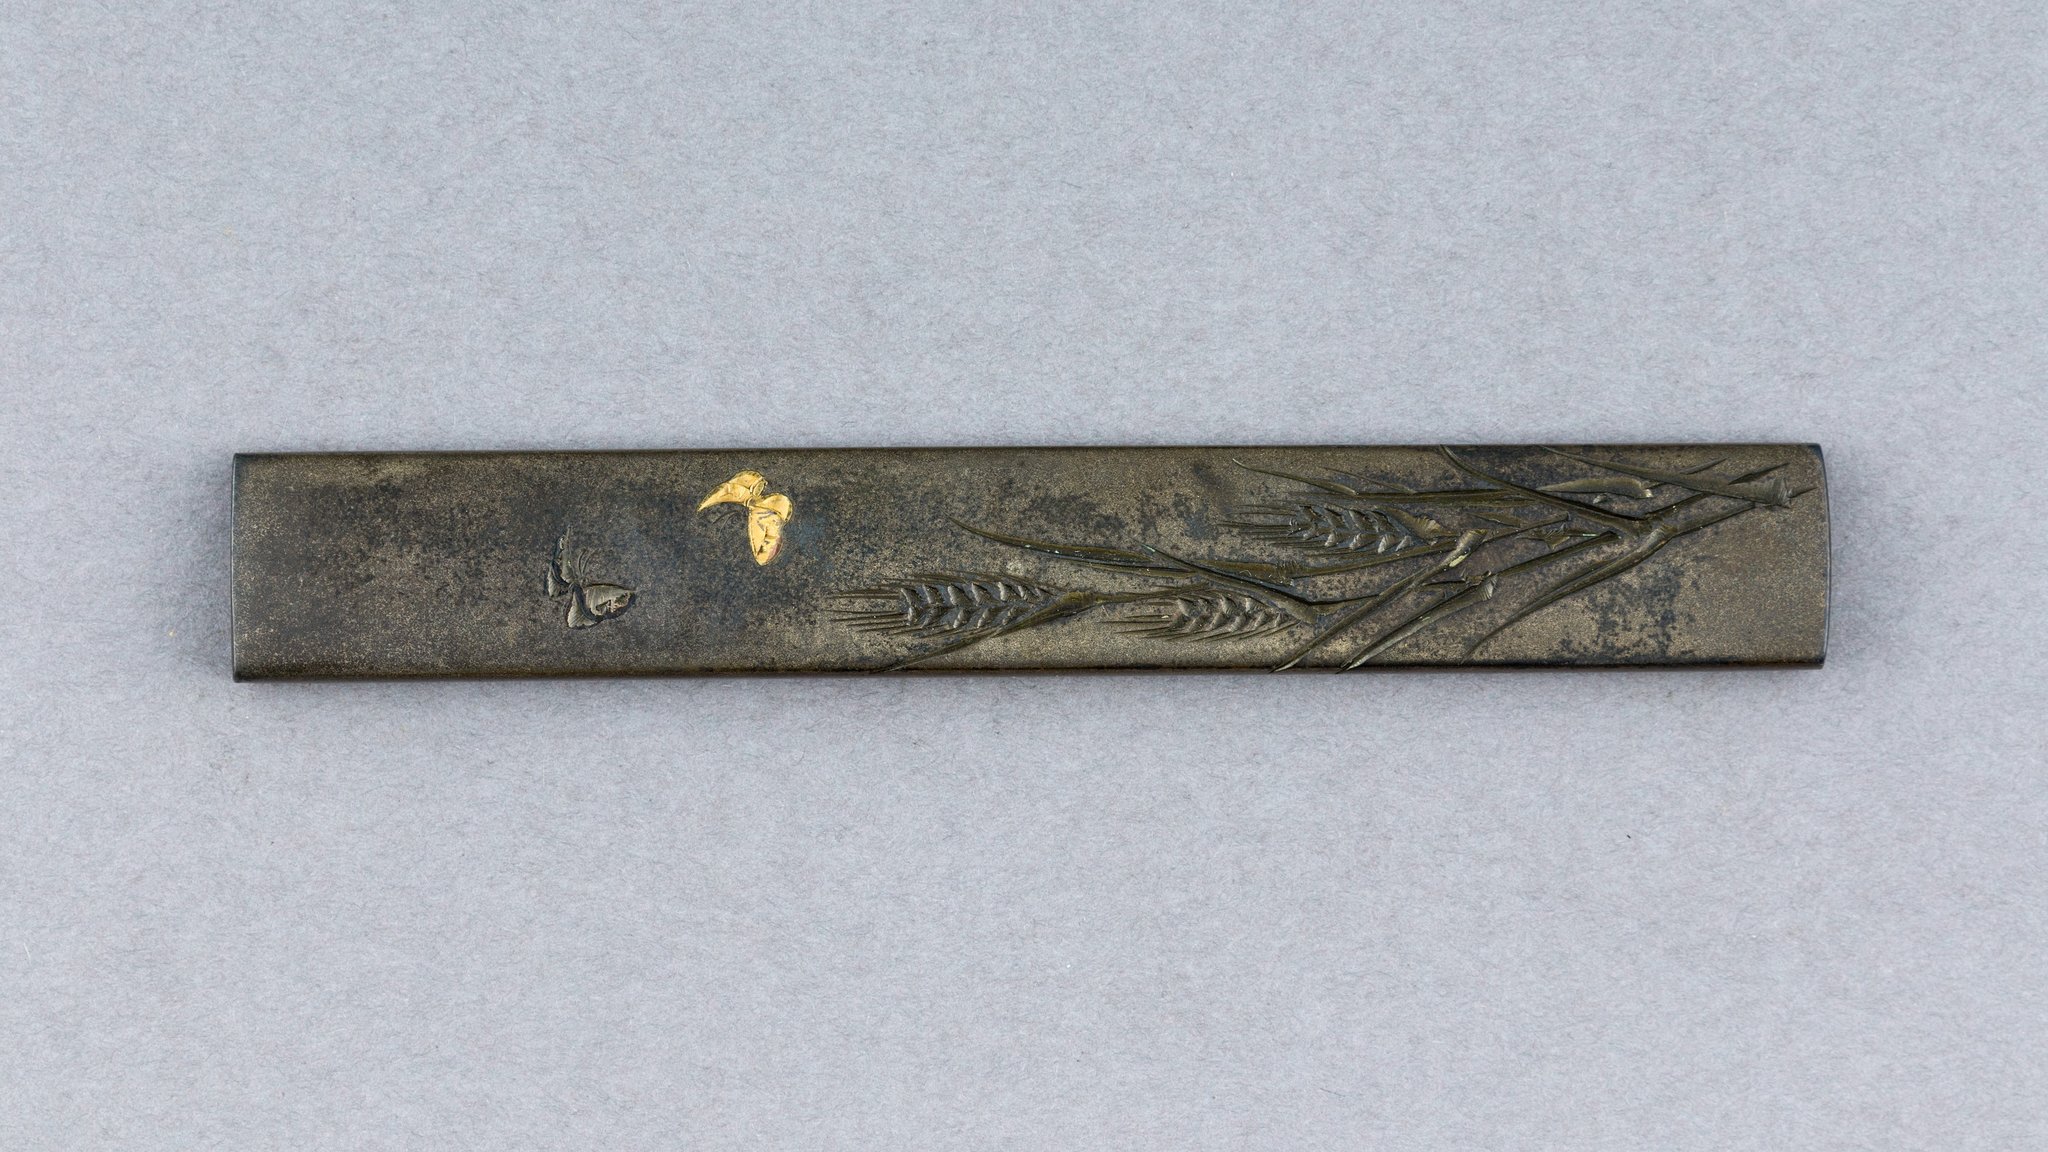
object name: knife handle kozuka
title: Knife Handle (Kozuka)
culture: japanese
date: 1801-1833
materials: silver alloy, gold, silver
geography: japan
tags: butterflies,plants